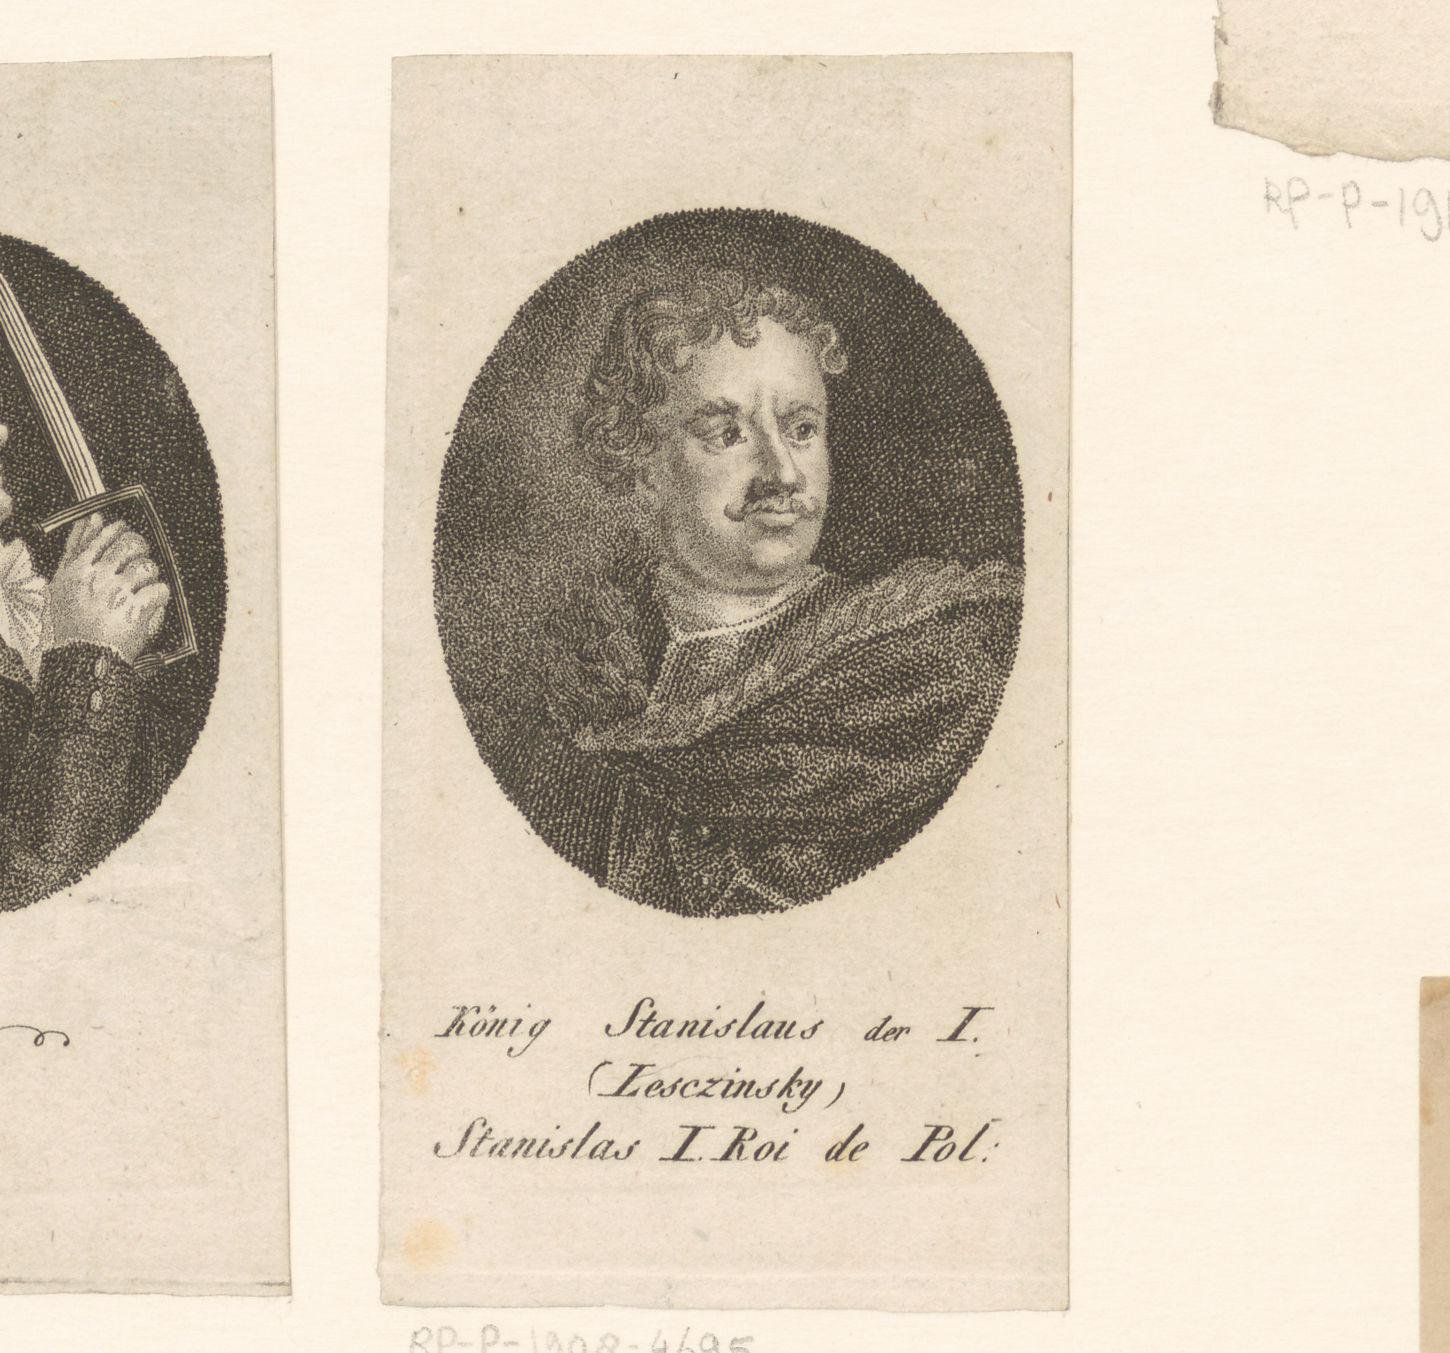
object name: print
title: Portret van Stanislaus Leszczyński, koning van Polen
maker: johann ferdinand krethlow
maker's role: artist, draughtsman, print maker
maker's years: 1767-1842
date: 1777-1842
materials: paper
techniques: stippling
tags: historical persons, king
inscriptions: collector's mark: Lugt 2228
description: Tekst in het Duits en het Frans in de ondermarge.